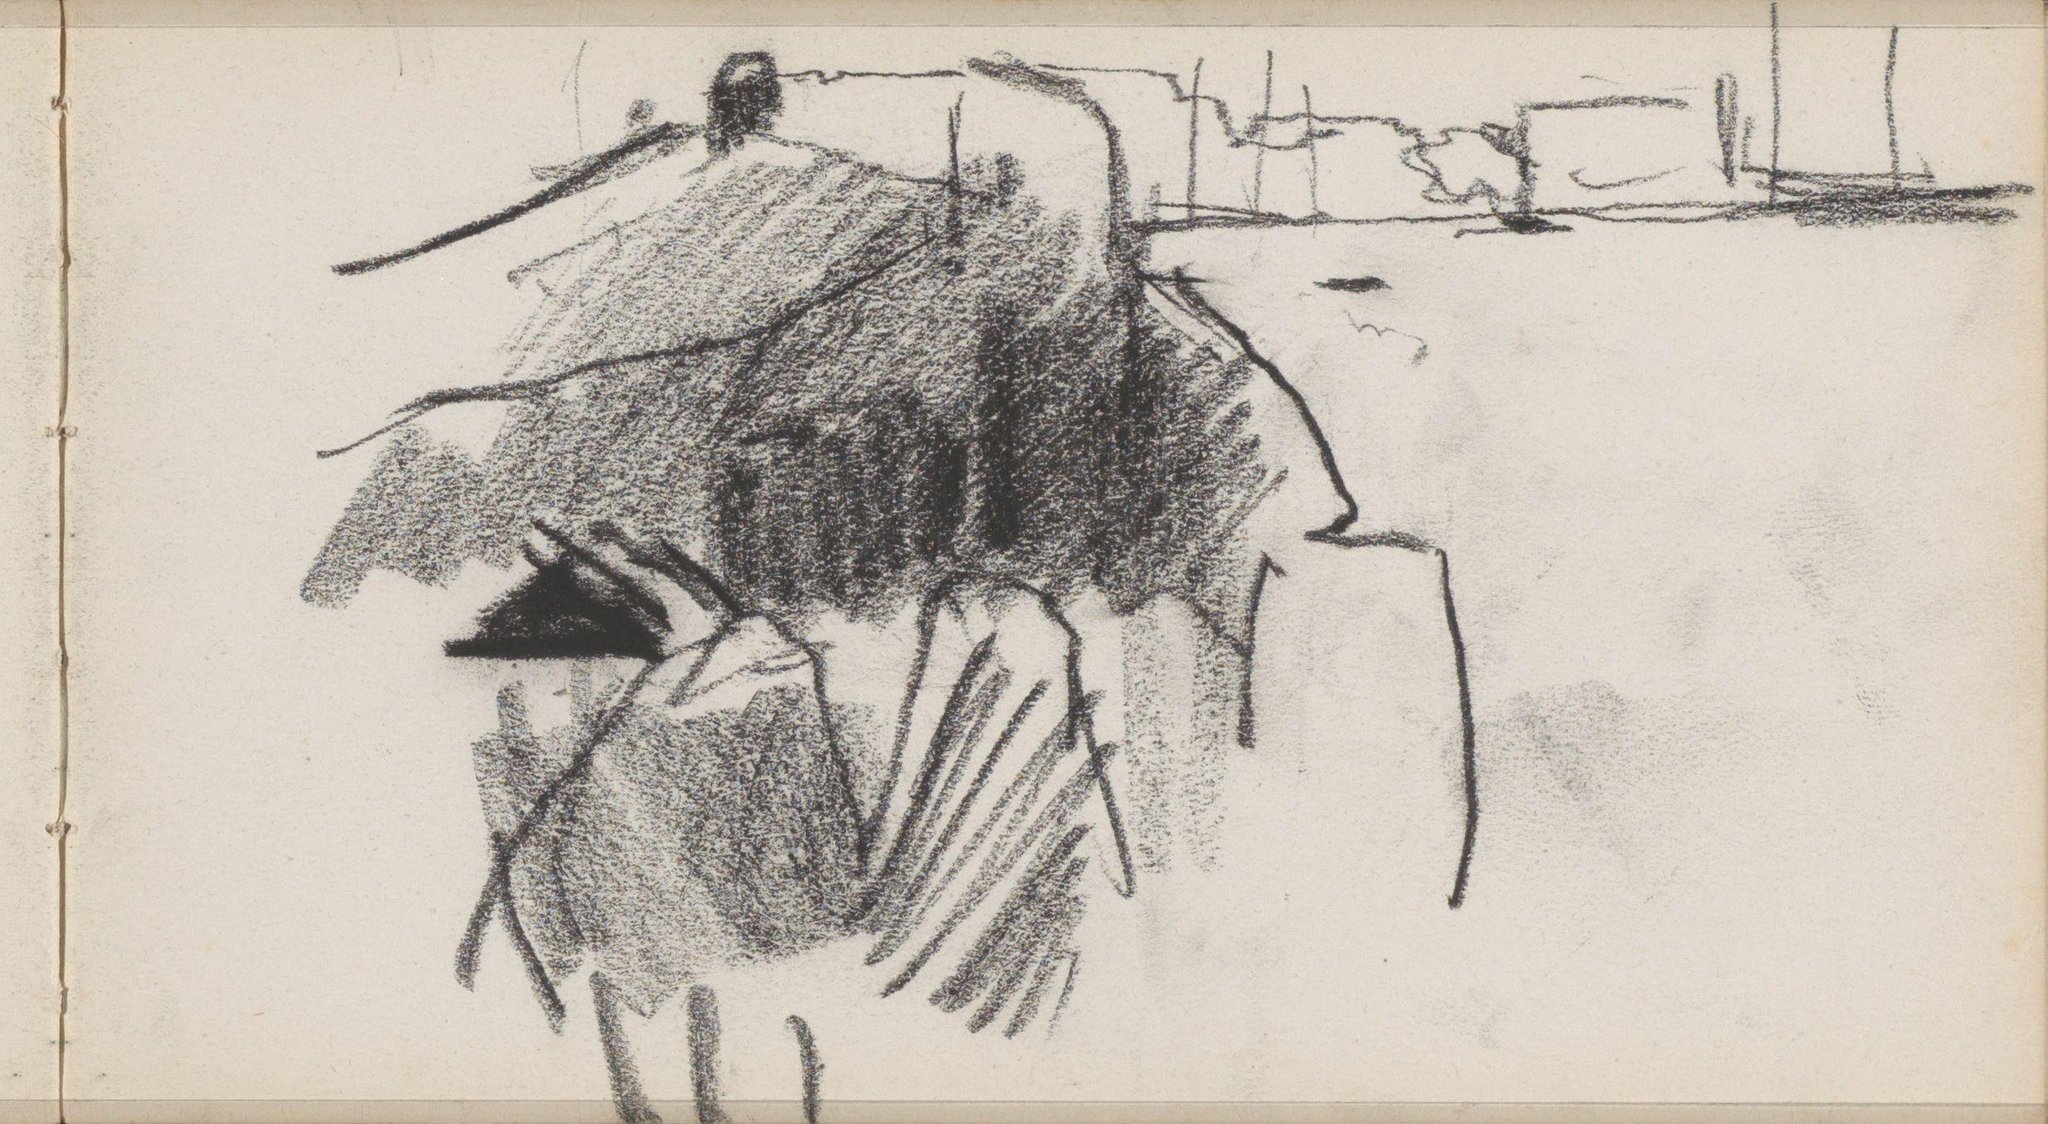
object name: sketchbook leaf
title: Studie, mogelijk van een stadsgezicht met water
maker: george hendrik breitner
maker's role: draughtsman, painter, print maker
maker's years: 1857-1923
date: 1886-1923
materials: chalk, paper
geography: amsterdam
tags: ships (in general), canals, waters (in city)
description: Pagina 26 uit een schetsboek met 39 bladen.